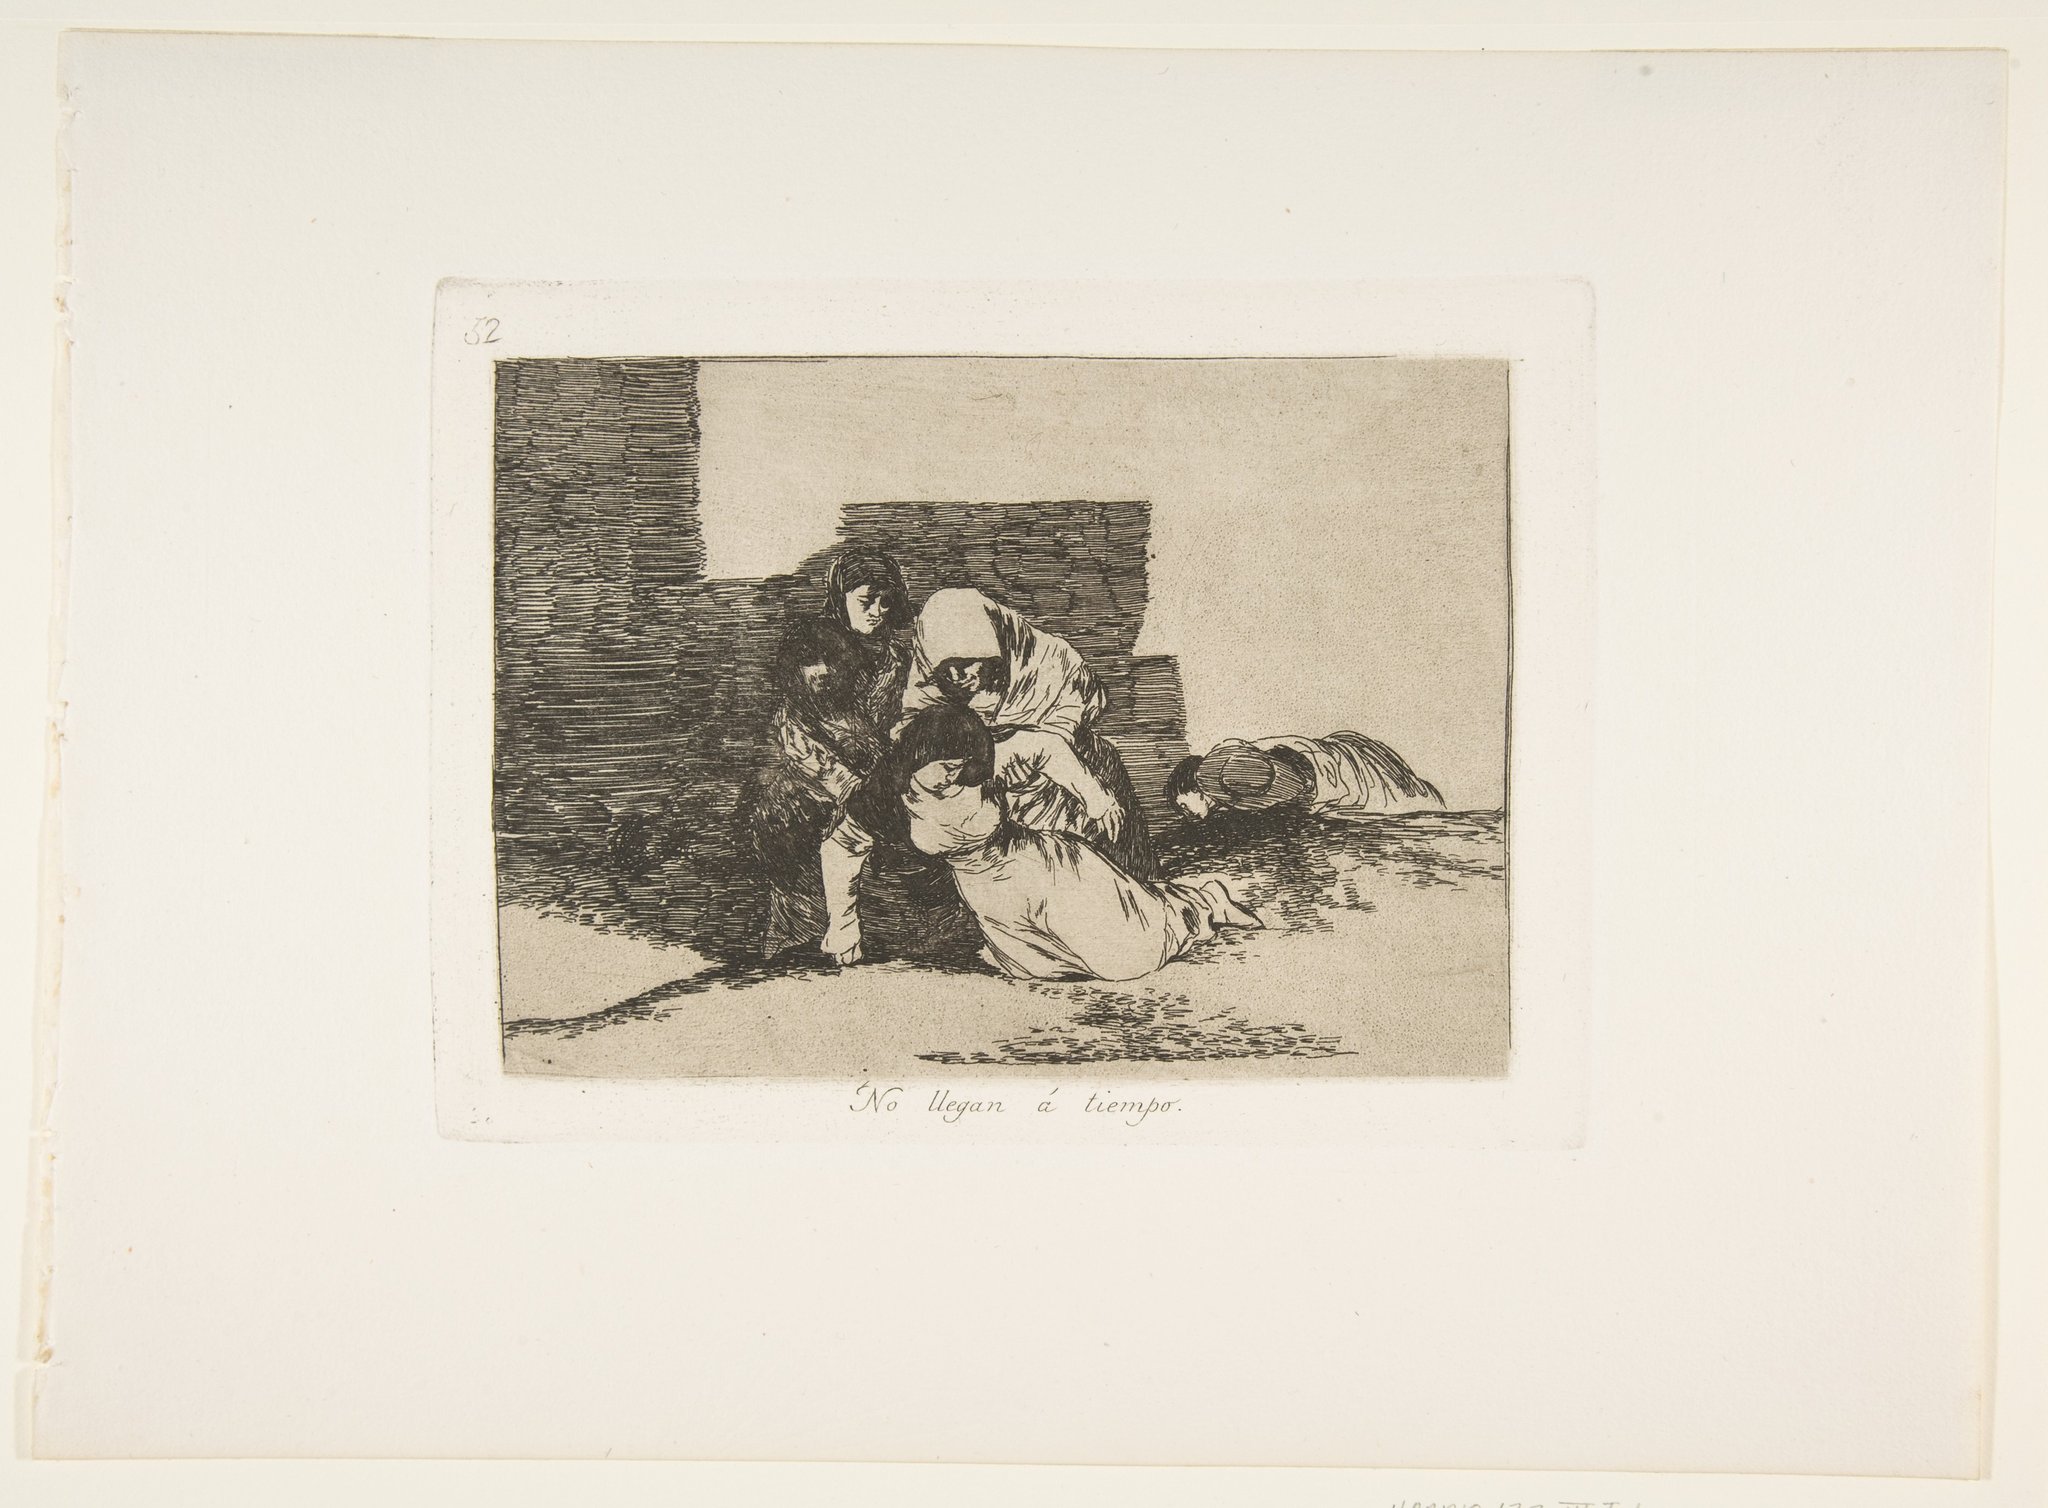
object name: print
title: Plate 52 from "The Disasters of War" (Los Desastres de la Guerra): 'They do not arrive in time' (No llegan á tiempo)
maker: goya (francisco de goya y lucientes)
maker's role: artist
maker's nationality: spanish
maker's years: 1746-1828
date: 1811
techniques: engraving, drypoint, etching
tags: women